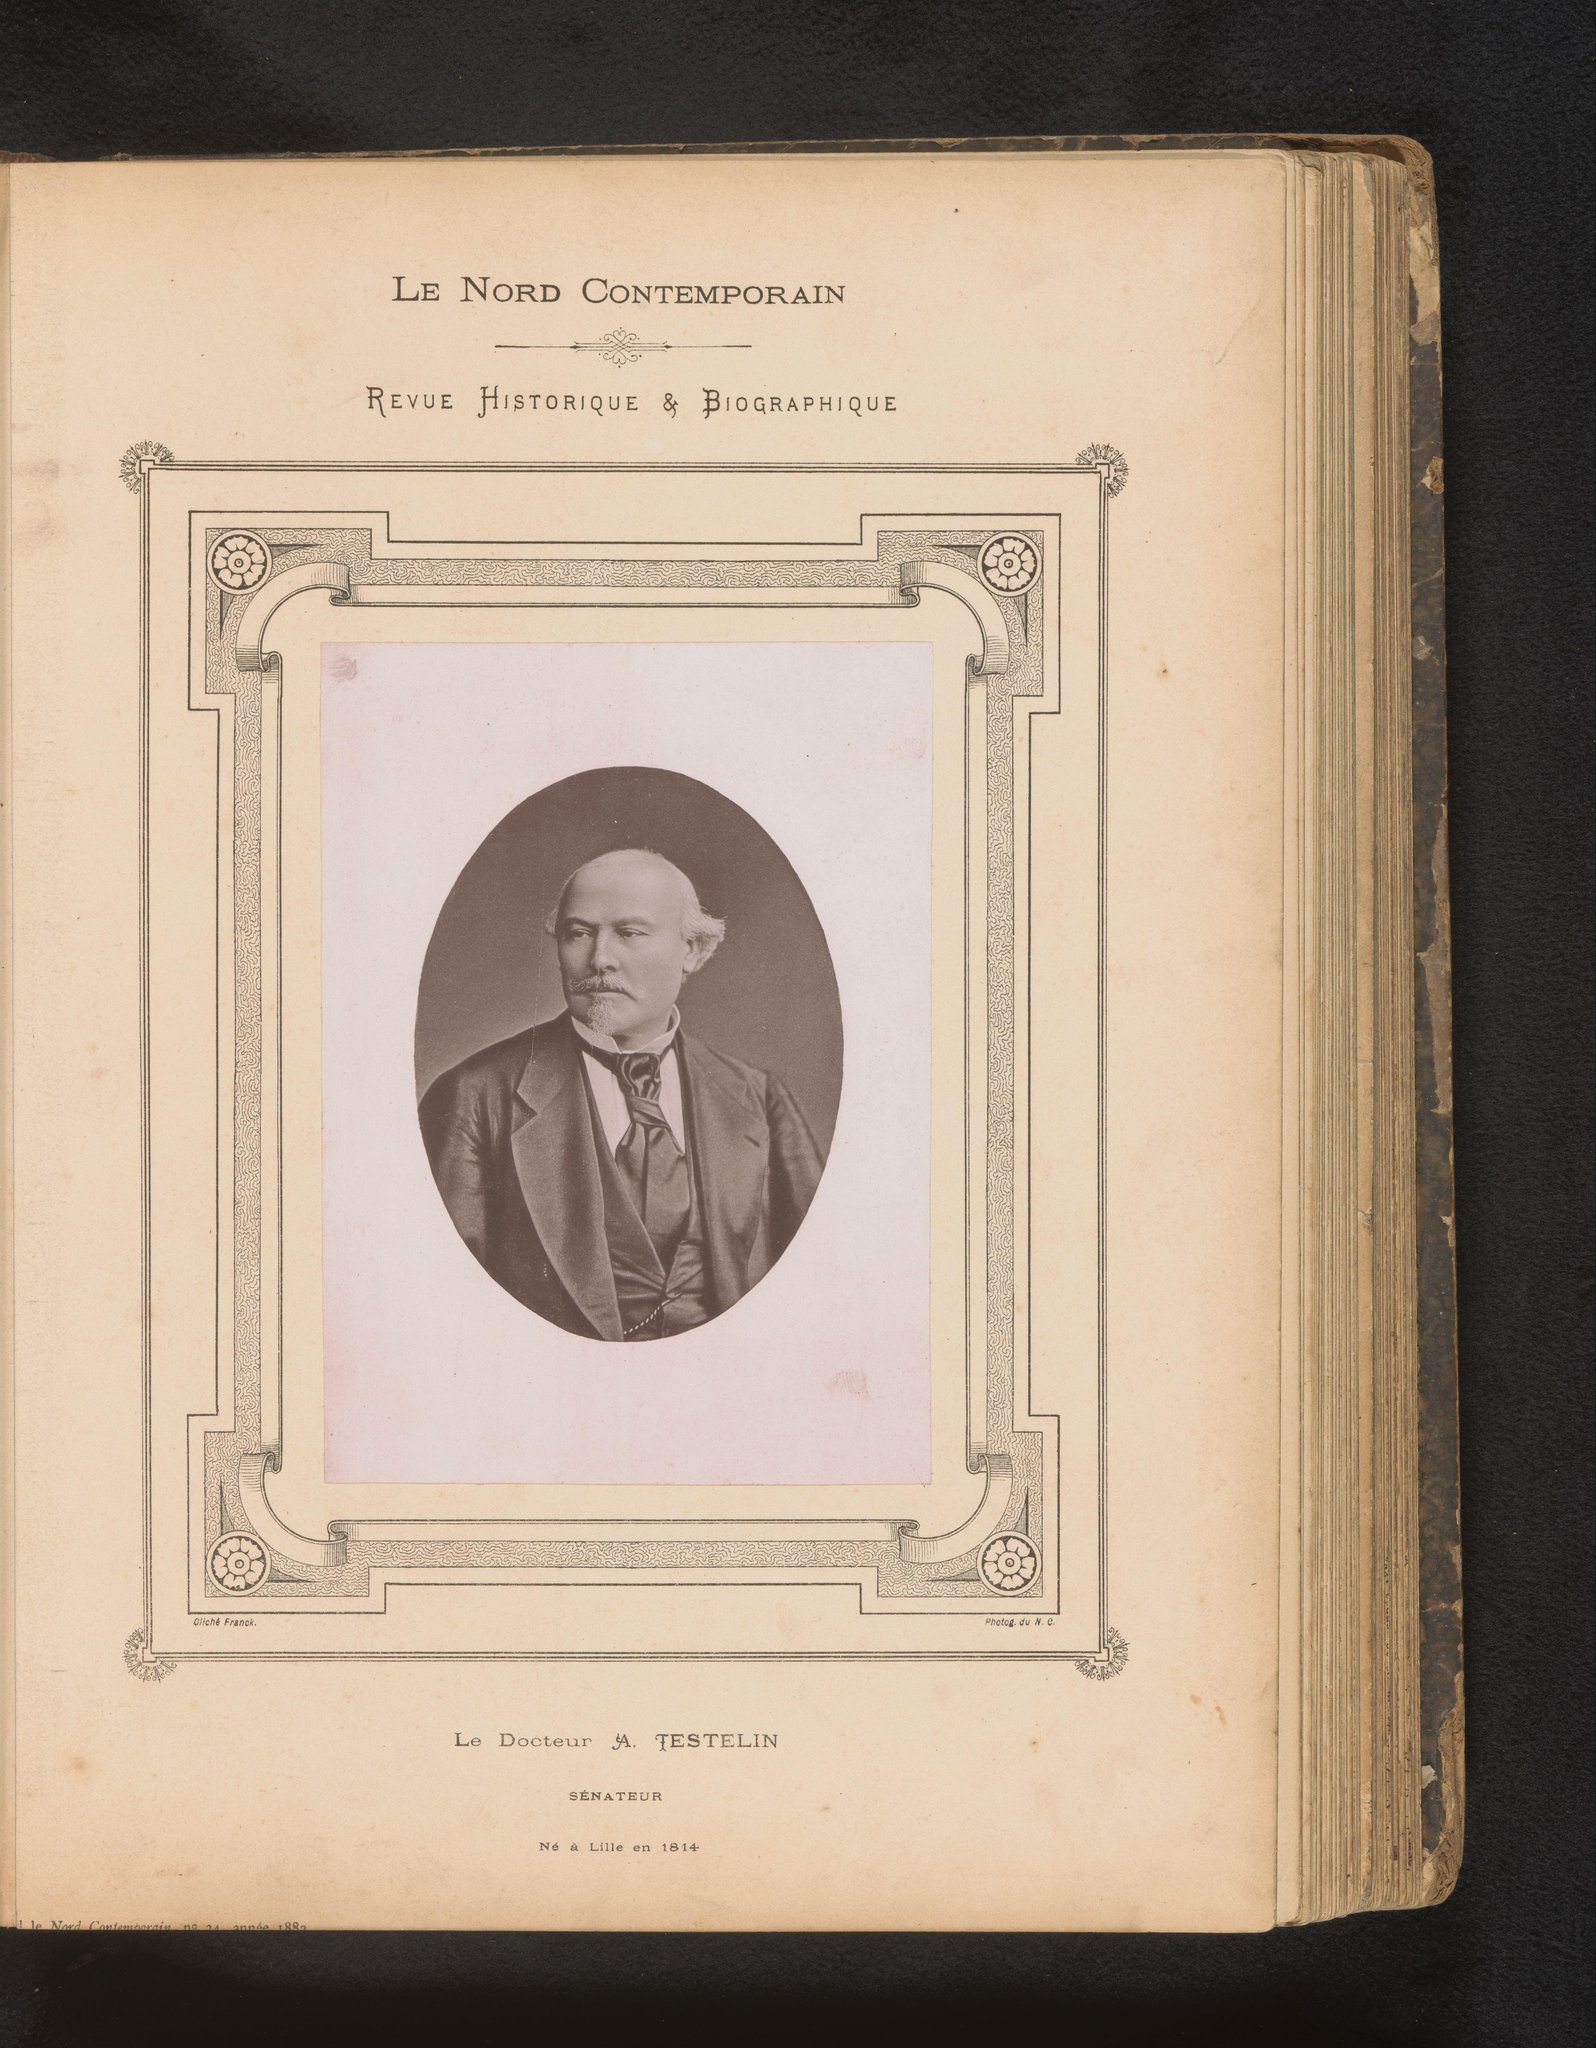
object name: photomechanical print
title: Le Docteur A. Testelin, Sénateur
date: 1877-1882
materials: paper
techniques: photograph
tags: lille, paris, historical persons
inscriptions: inscription: ‘Le Nord Contemporain/ Revue Historique & Biographique’, inscription: ‘[Journal le Nord Contemporain, No 24, année 1882.]’, inscription: ‘Né à Lille en 1814’